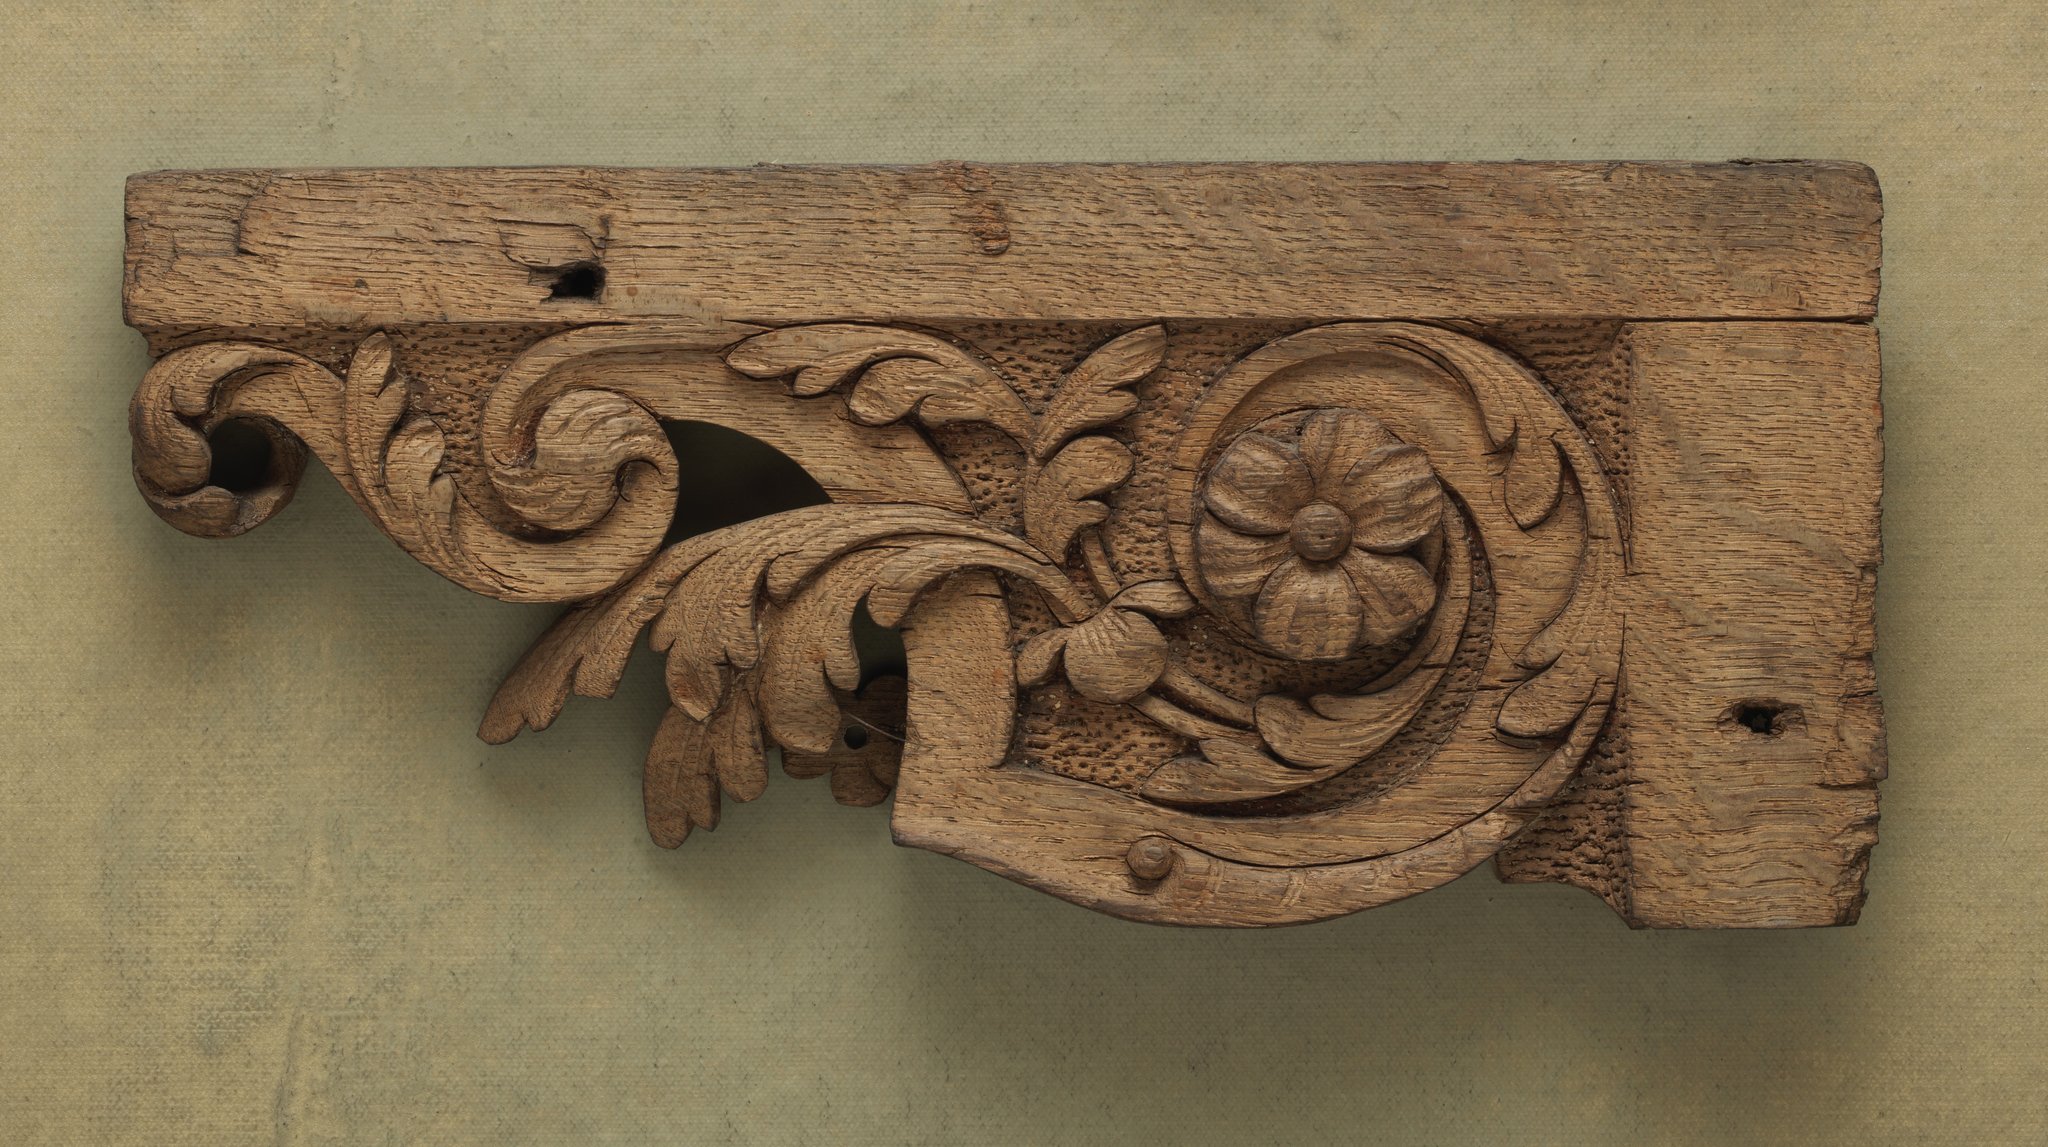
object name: bracket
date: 1601-1700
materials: wood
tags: flowers